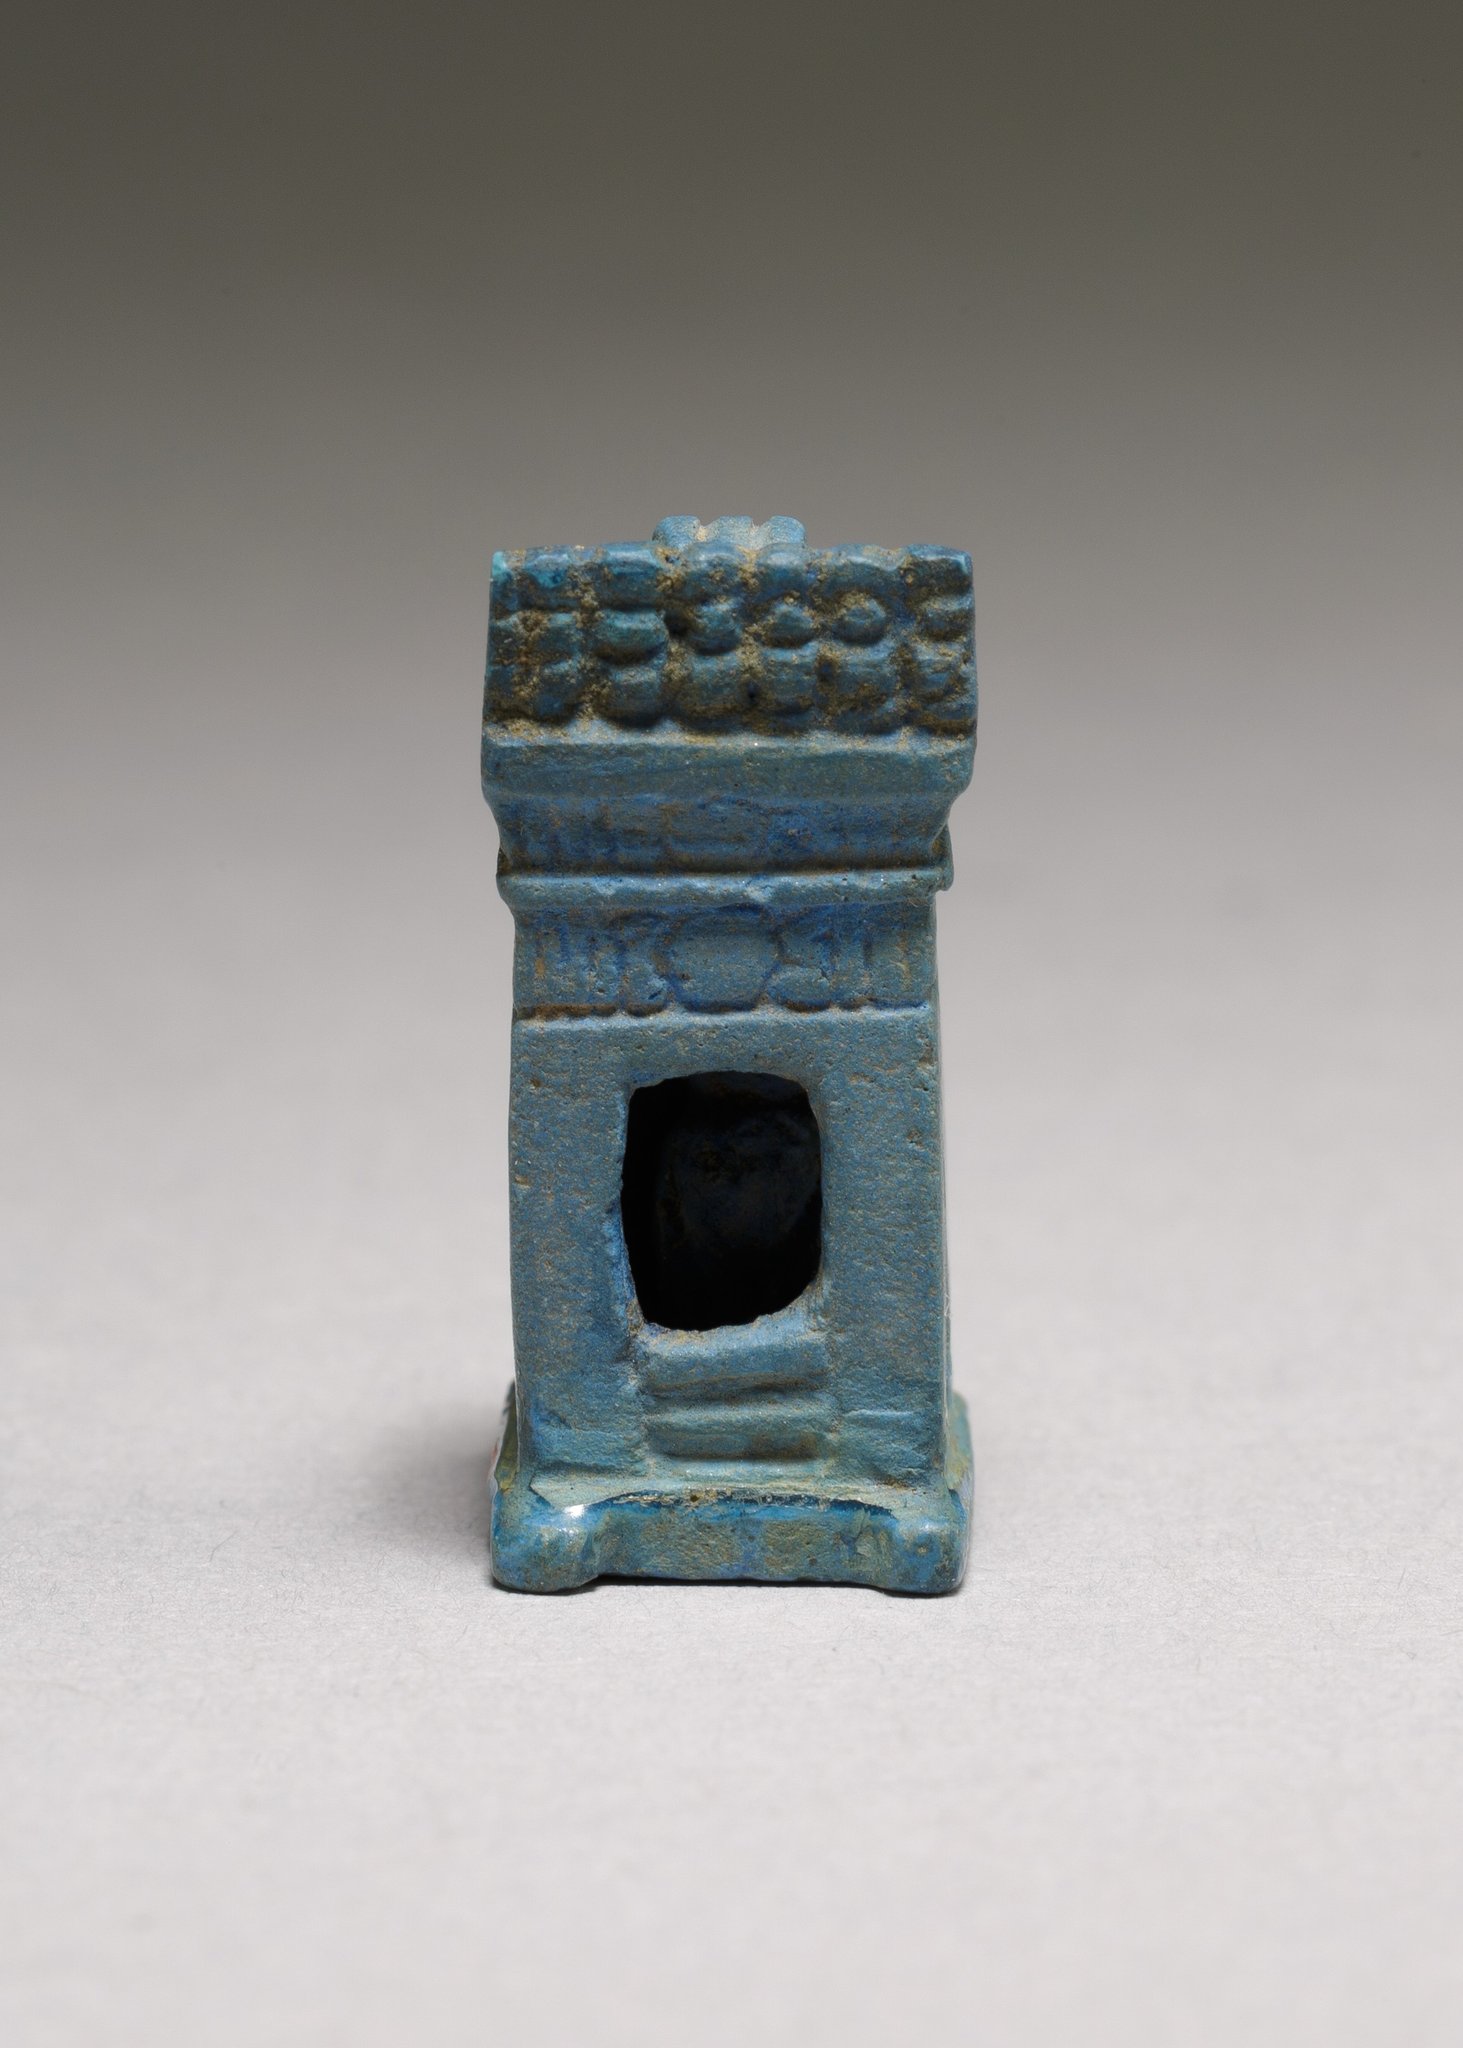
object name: shrine amulet, khonsu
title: Khonsu shrine amulet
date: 664-332 BCE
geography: egypt